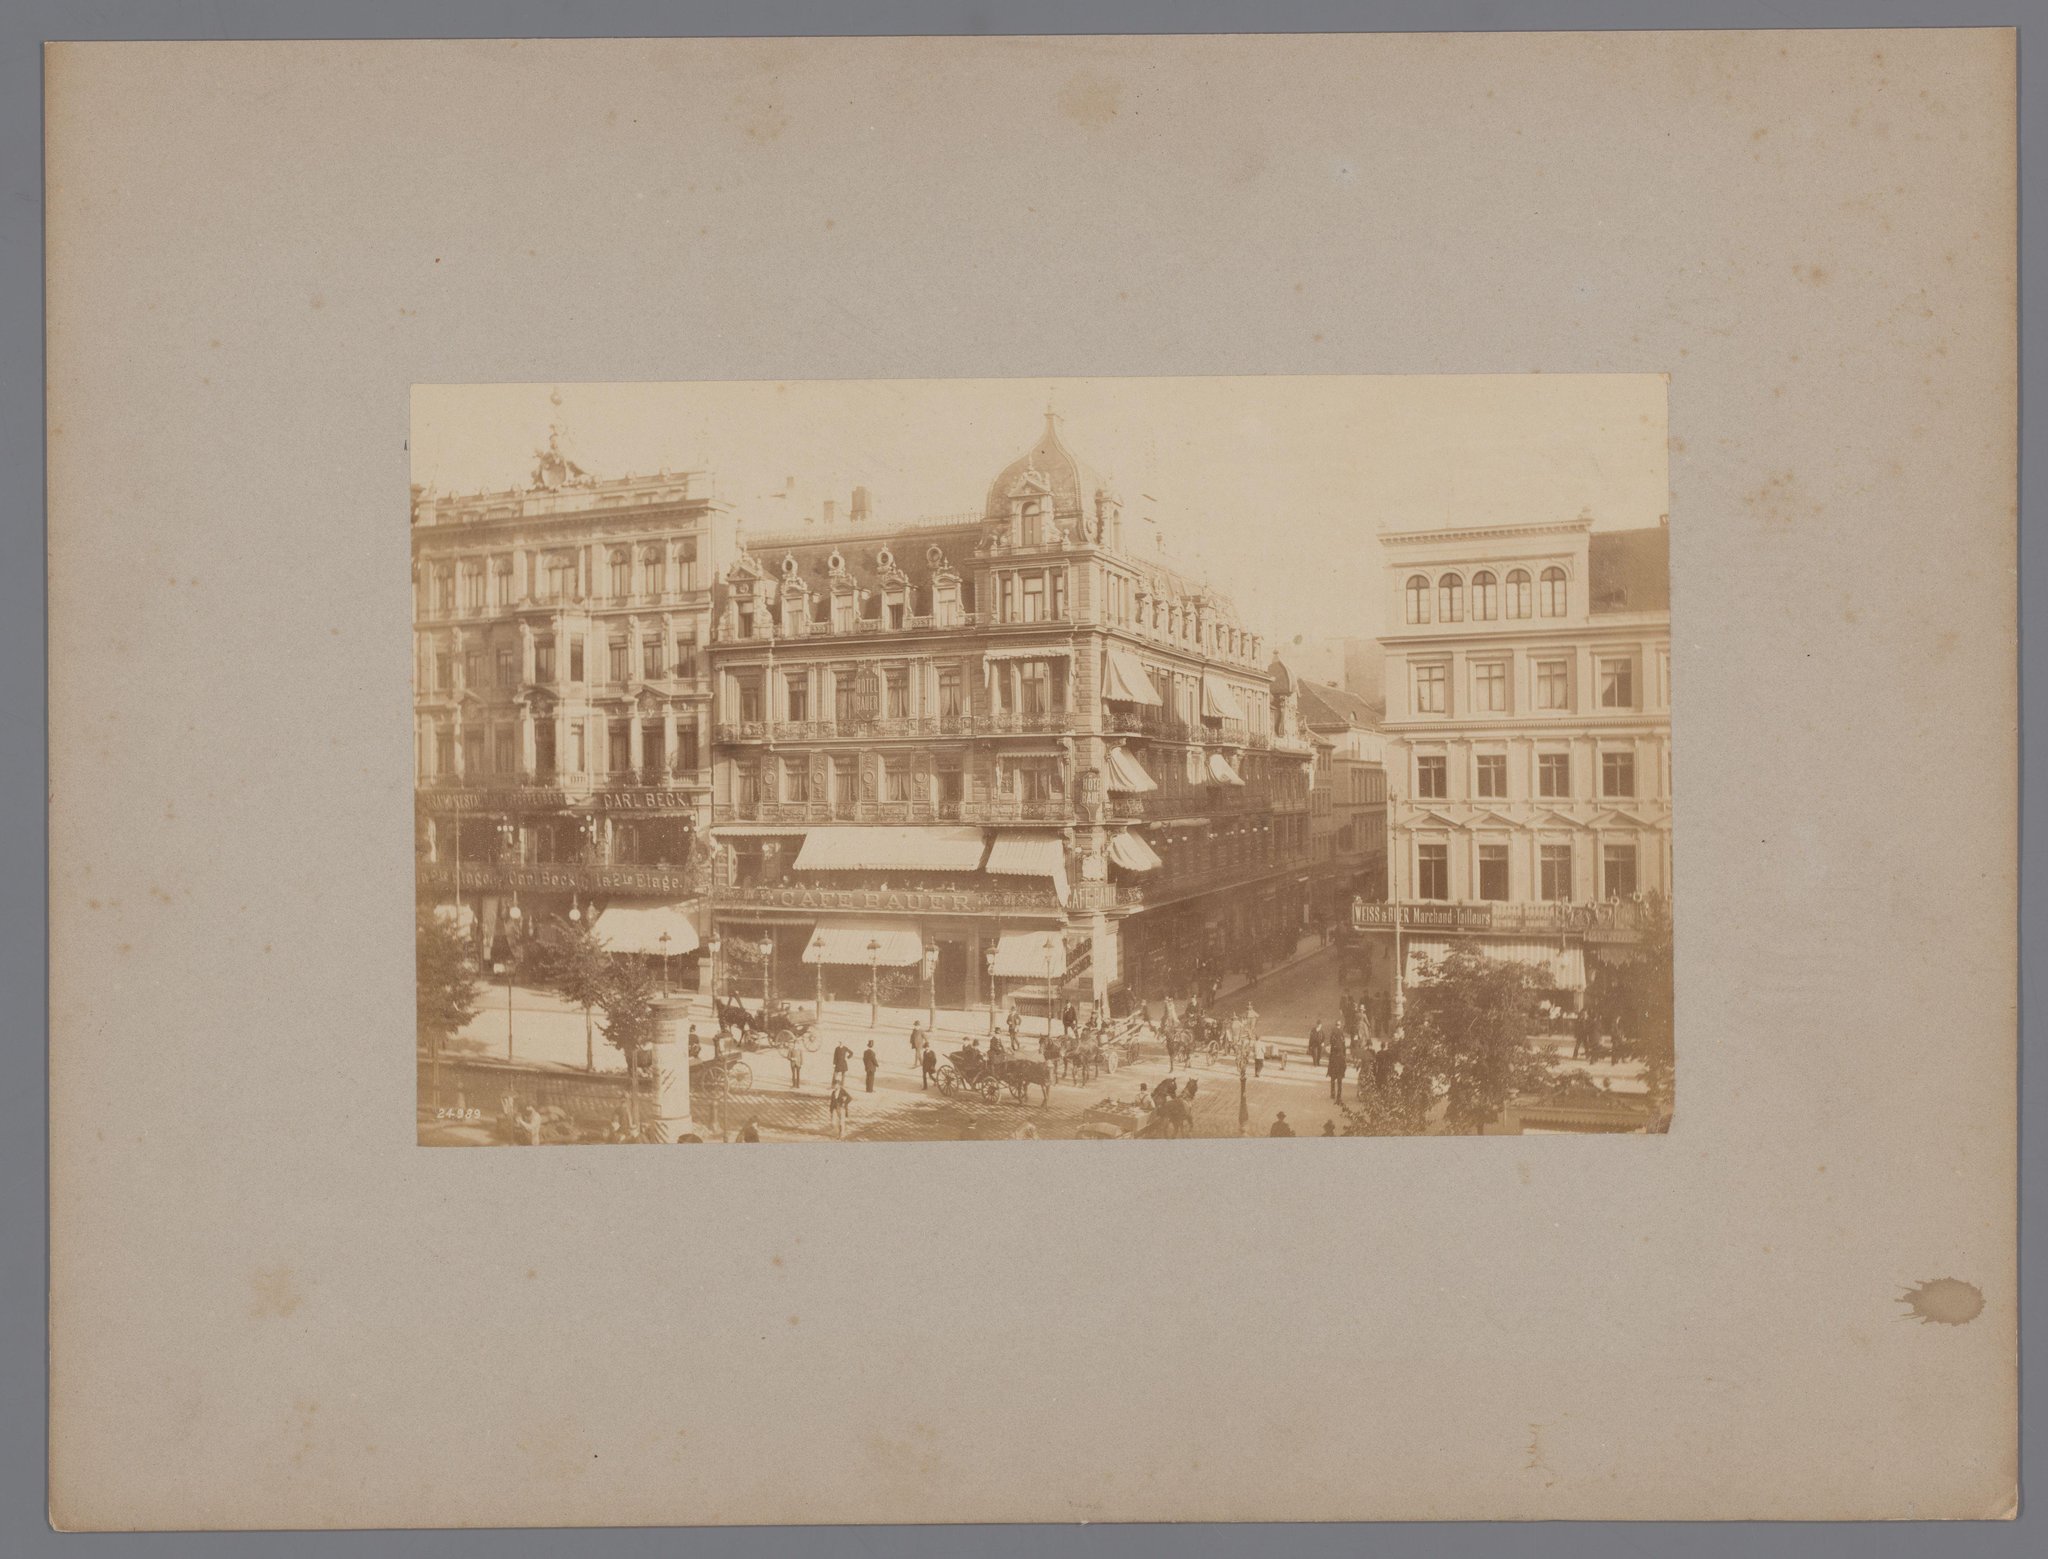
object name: photograph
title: Café Bauer, Unter den Linden, Berlijn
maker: Anonymous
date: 1880-1900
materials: cardboard, photographic support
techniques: albumen print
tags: unter den linden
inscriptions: inscription: ‘Berlin’, number: ‘24989’